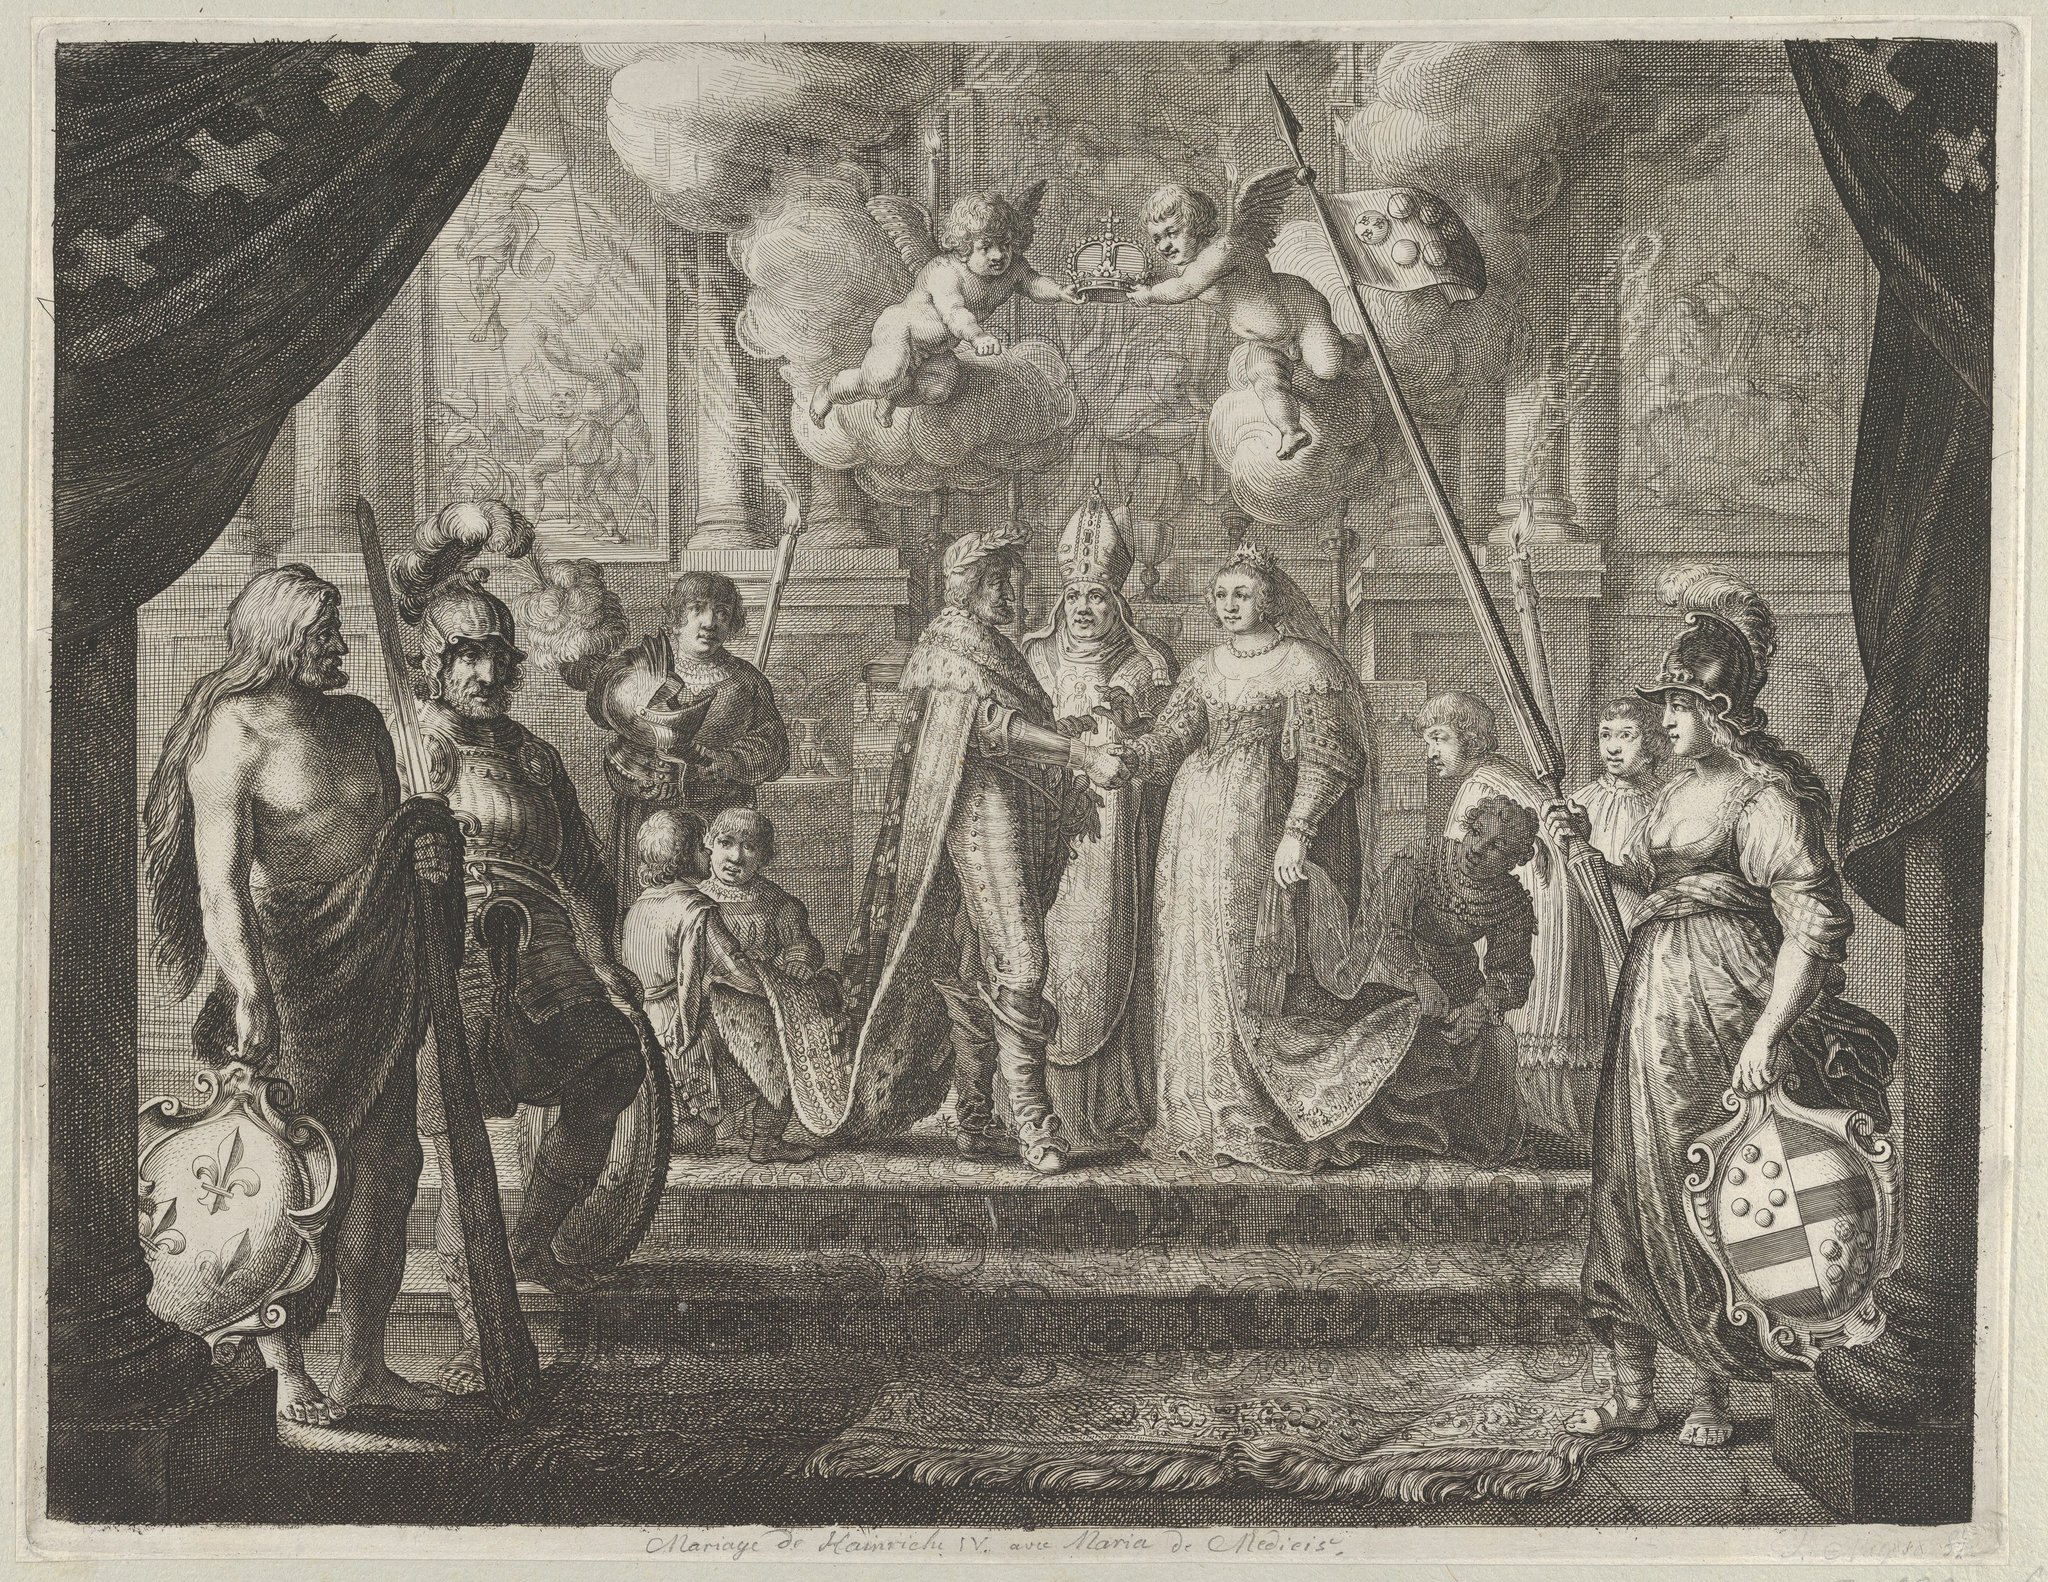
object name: print, fete, ornament architecture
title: Plate 3: The Marriage of Henry IV and Marie de Medici, from Caspar Barlaeus, "Medicea Hospes"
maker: pieter nolpe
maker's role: artist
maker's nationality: dutch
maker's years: 1613-1614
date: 1638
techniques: etching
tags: men,women,hercules,putti,mars,weddings